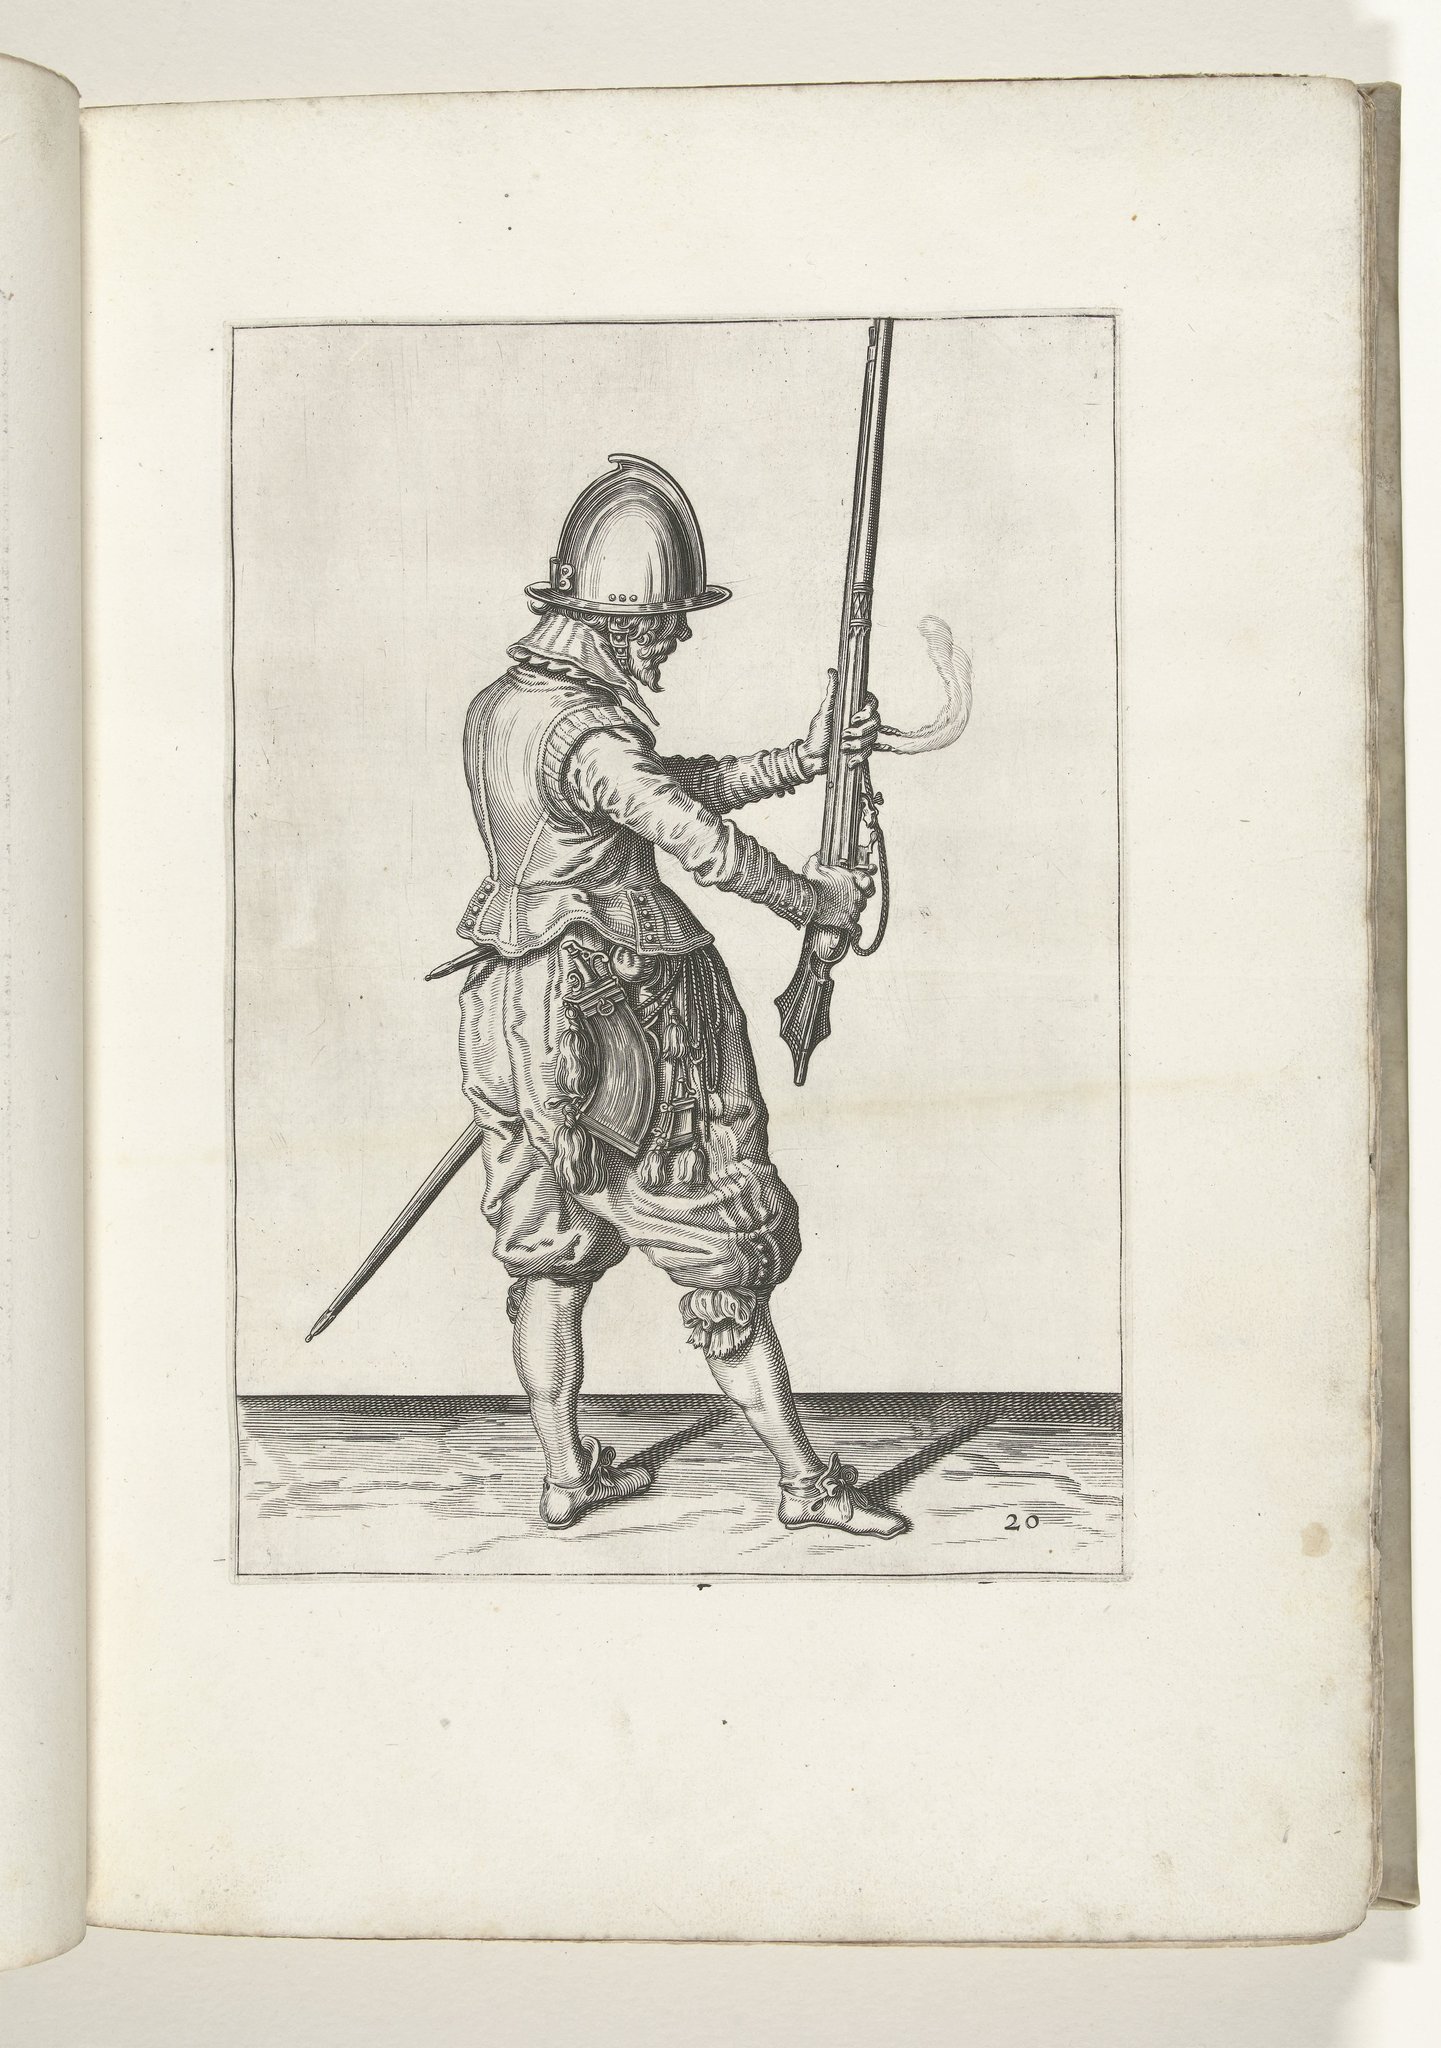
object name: print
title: Soldaat die zijn roer met beide handen rechtop voor zich vasthoudt (nr. 20), ca. 1600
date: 1597-1607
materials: paper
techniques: engraving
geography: northern netherlands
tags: maurice (prince of orange), handling of weapons ~ military training, weapons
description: Een soldaat, ten voeten uit, naar rechts, die een roer (een bepaald type vuurwapen) met beide handen voor zich vasthoudt, de loop omhoog wijzend, om het naar zijn linkerzijde te brengen (nr. 20), ca. 1600. In zijn linkerhand behalve de loop van het roer ook een brandende lont. Plaat 20 in de instructies voor het hanteren van de roer: Corte onderwysinghe op de figuerliicke afbeeldinghe, belanghende t'rechte ghebruyck des Roers. Onderdeel van de illustraties in: J. de Gheyn, Wapenhandelinghe van Roers Musquetten ende spiessen, 's-Gravenhage, 1607. Krijgswezen rond 1600.